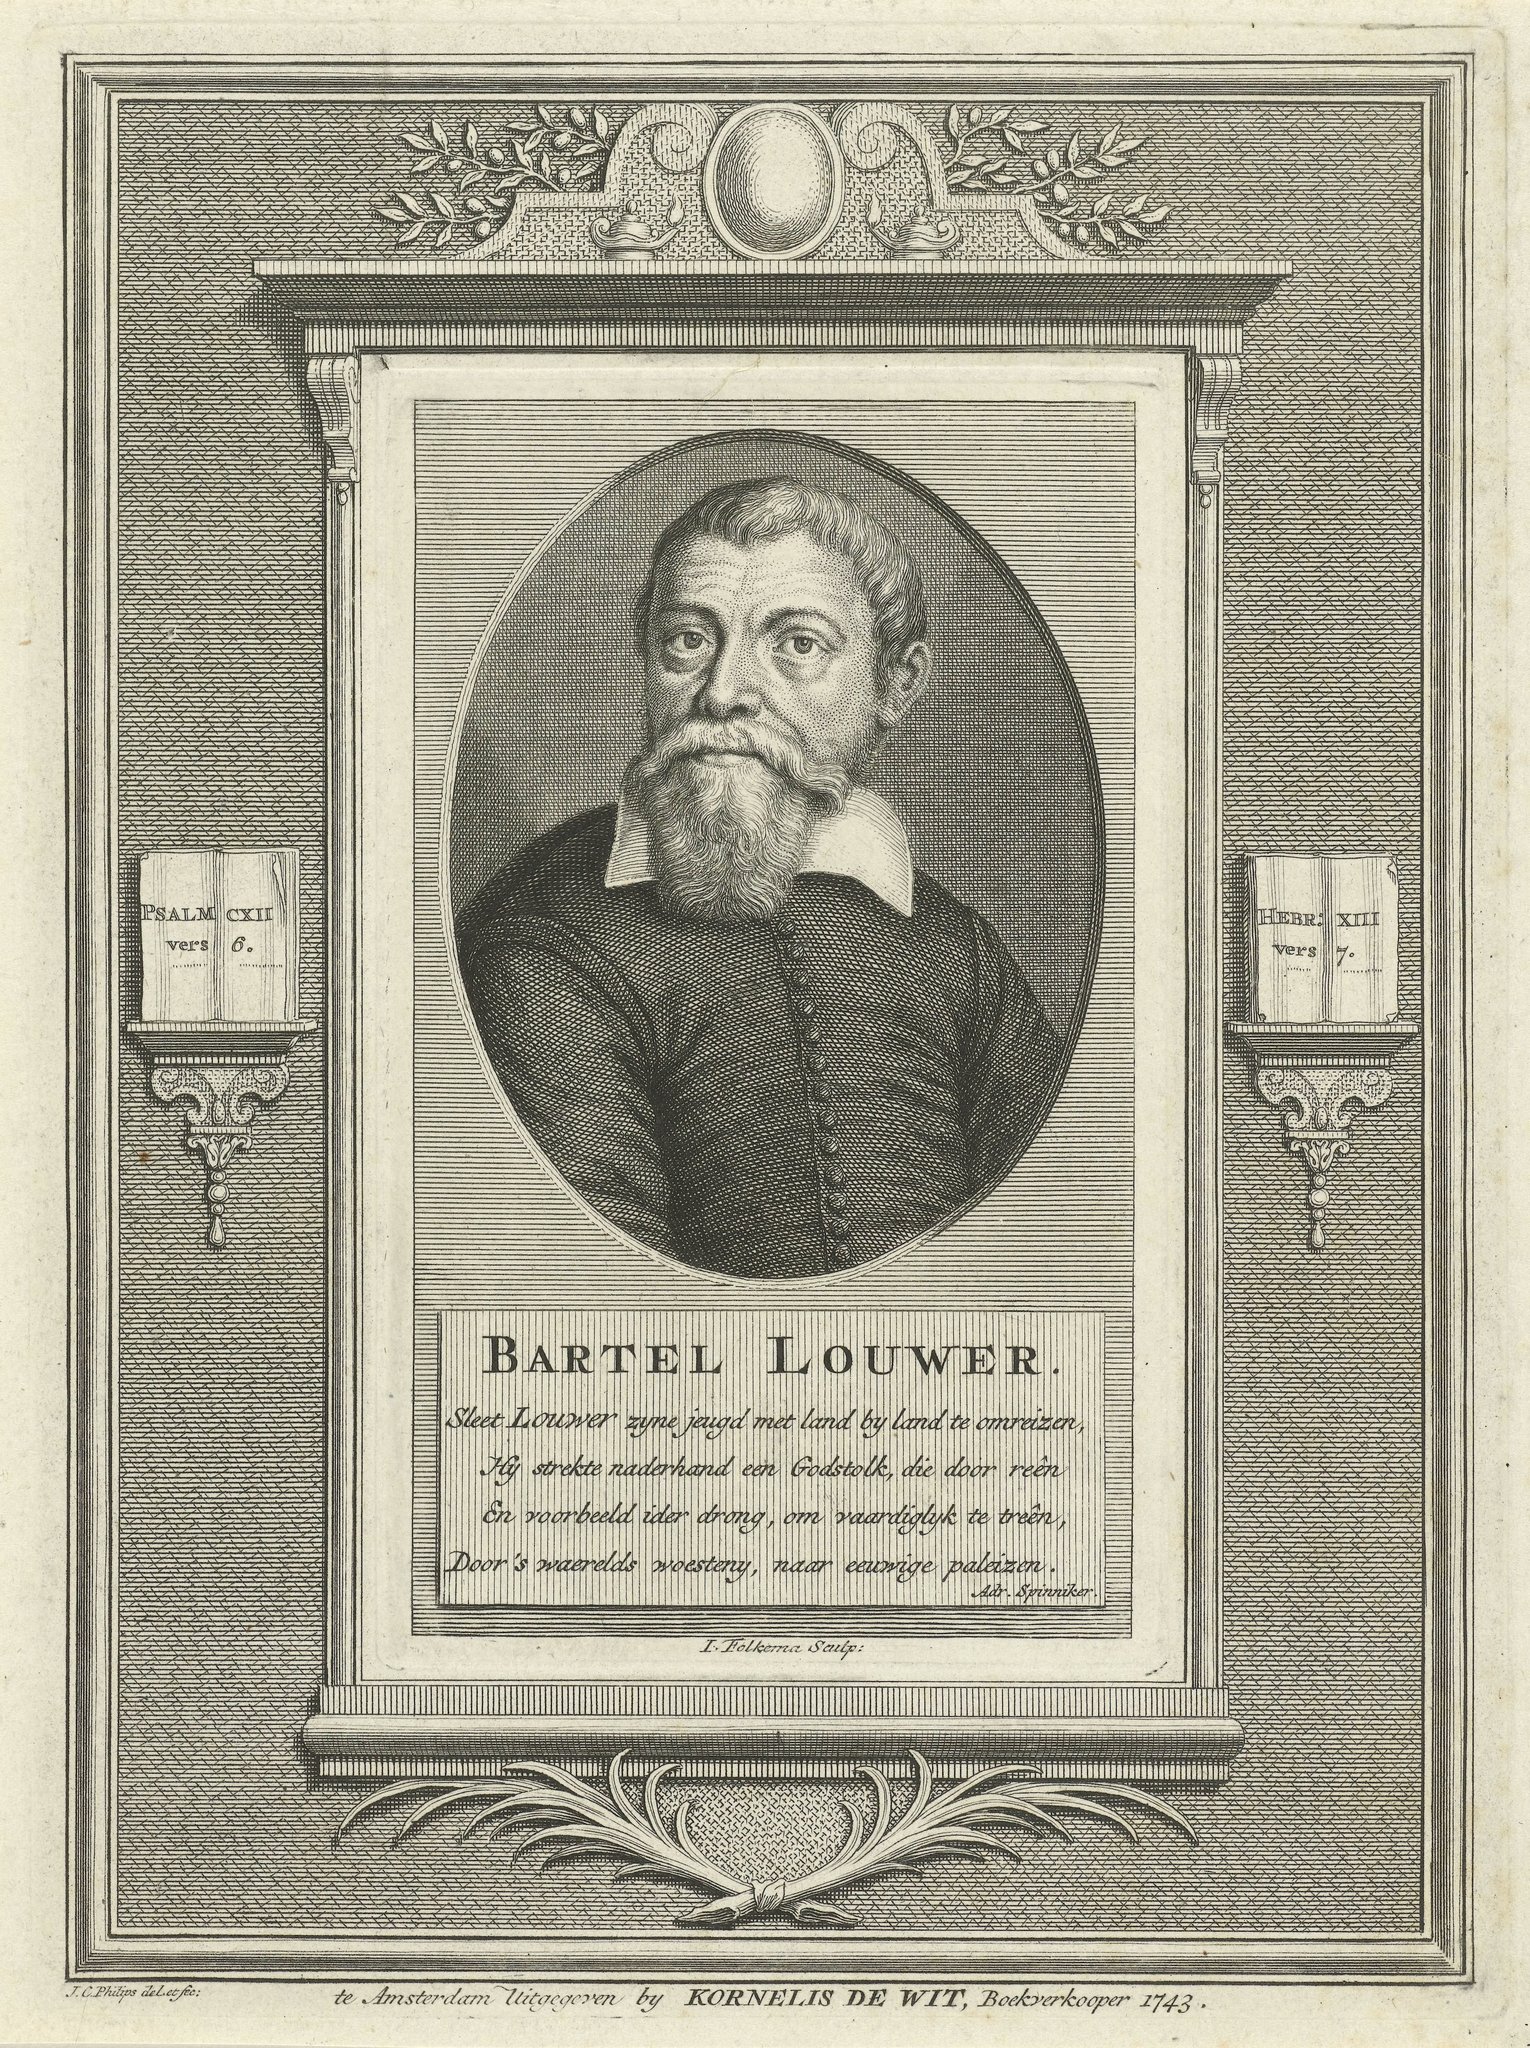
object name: print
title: Portret van Bartel Louwer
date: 1743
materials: paper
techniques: engraving, etching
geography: amsterdam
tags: predikant, bartel louwer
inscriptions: collector's mark: Lugt 2228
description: Prent gedrukt van twee platen: Portretbuste in ovaal van predikant Bartel Louwer, blootshoofds en iets naar rechts. Onder het portret staan de naam van de geportretteerde en een vierregelig vers in het Nederlands. Het portret is omlijst met een ornamentele rand, gedrukt van een andere plaat, en versierd met palmbladeren en olijftakken. Links en rechts van het portret staan verwijzingen naar bijbelverzen.